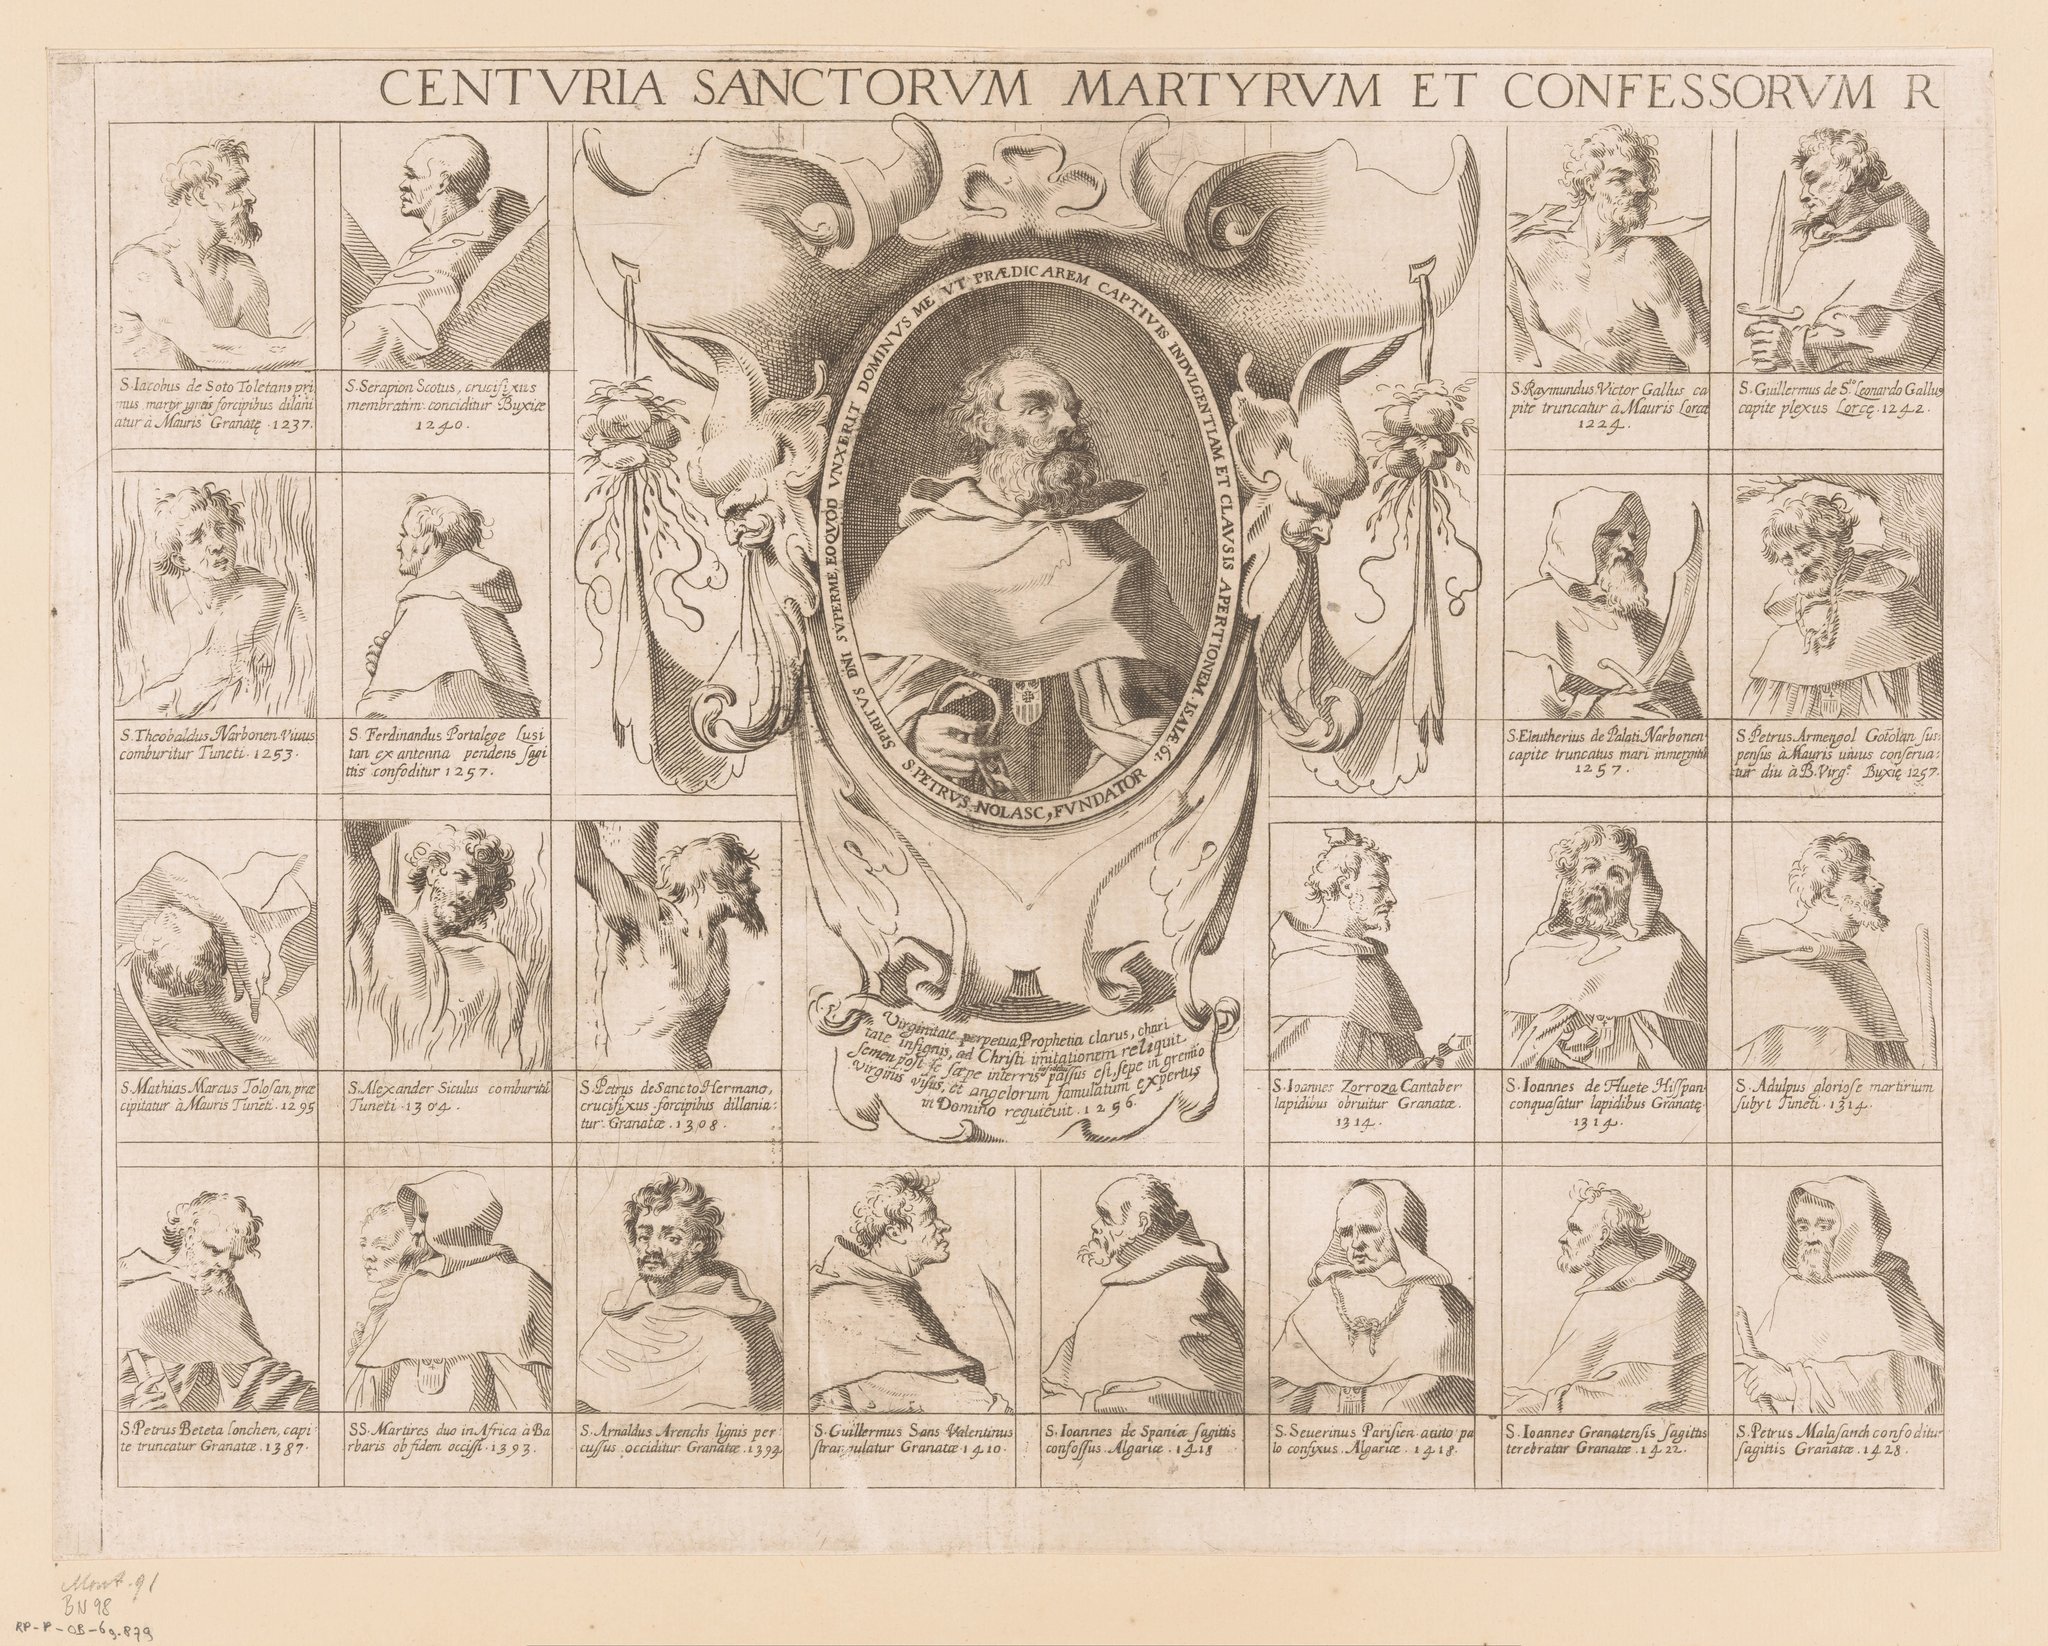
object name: print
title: Centuria Sanctorum Martyrum Et Confessorum Regalis Ordinis Redemptorum S. Maria De Mercede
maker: claude mellan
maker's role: draughtsman, print maker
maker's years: 1598-1688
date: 1624-1636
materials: paper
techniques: engraving, etching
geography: rome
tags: the co-founder of the mercedarians, peter nolasco; possible attributes: badge (or banner) with the arms of aragon, captives, broken chains, double cross, olive-branch, saints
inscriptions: collector's mark: Lugt 240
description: Plaat linksboven van geheel bestaande uit vier platen met 98 martelaren van de Orde van Notre-Dame-de-la-Merci, ook wel Mercedariërs genoemd, met twee portretten van Peter Nolasco en Raymundus Nonnatus in ovalen.